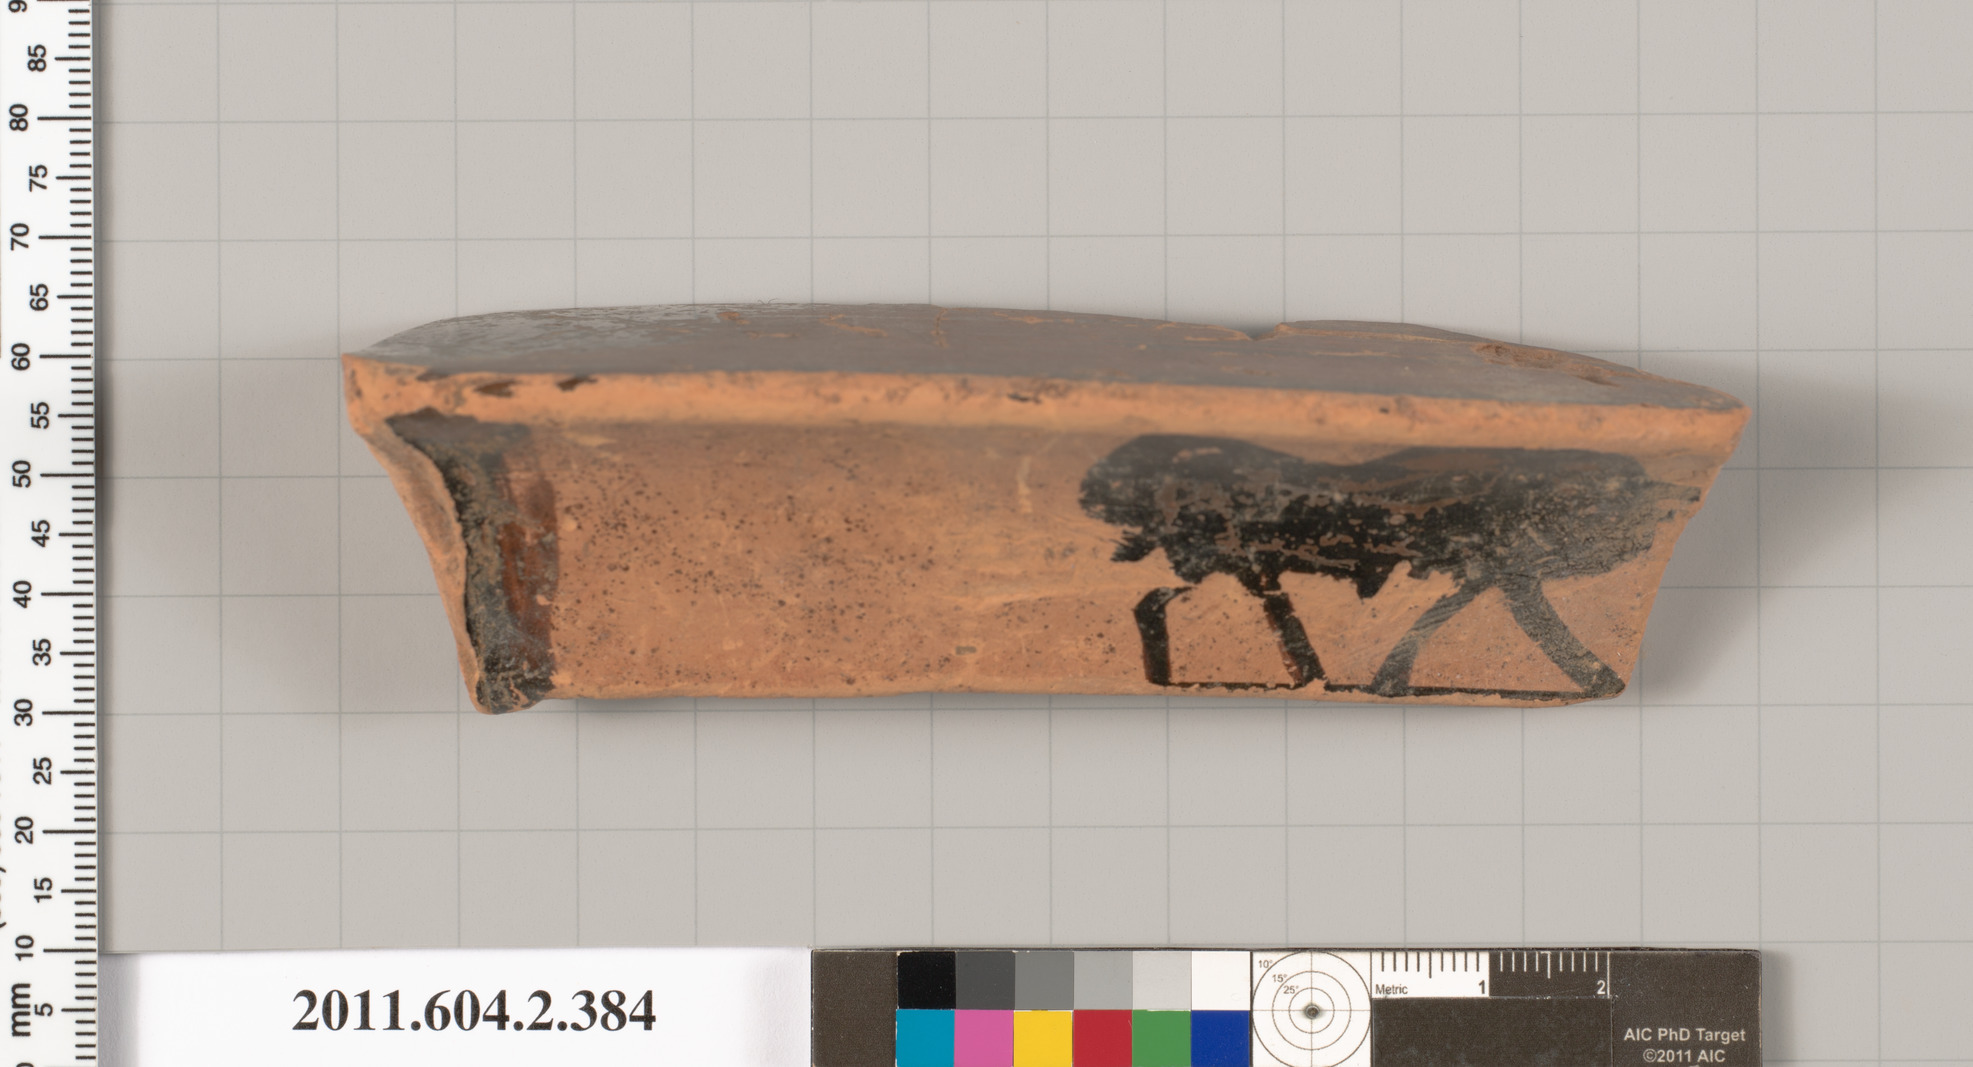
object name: column krater fragment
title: Terracotta fragment of a column-krater (bowl for mixing wine and water)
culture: greek, attic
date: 467-435 BCE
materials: terracotta